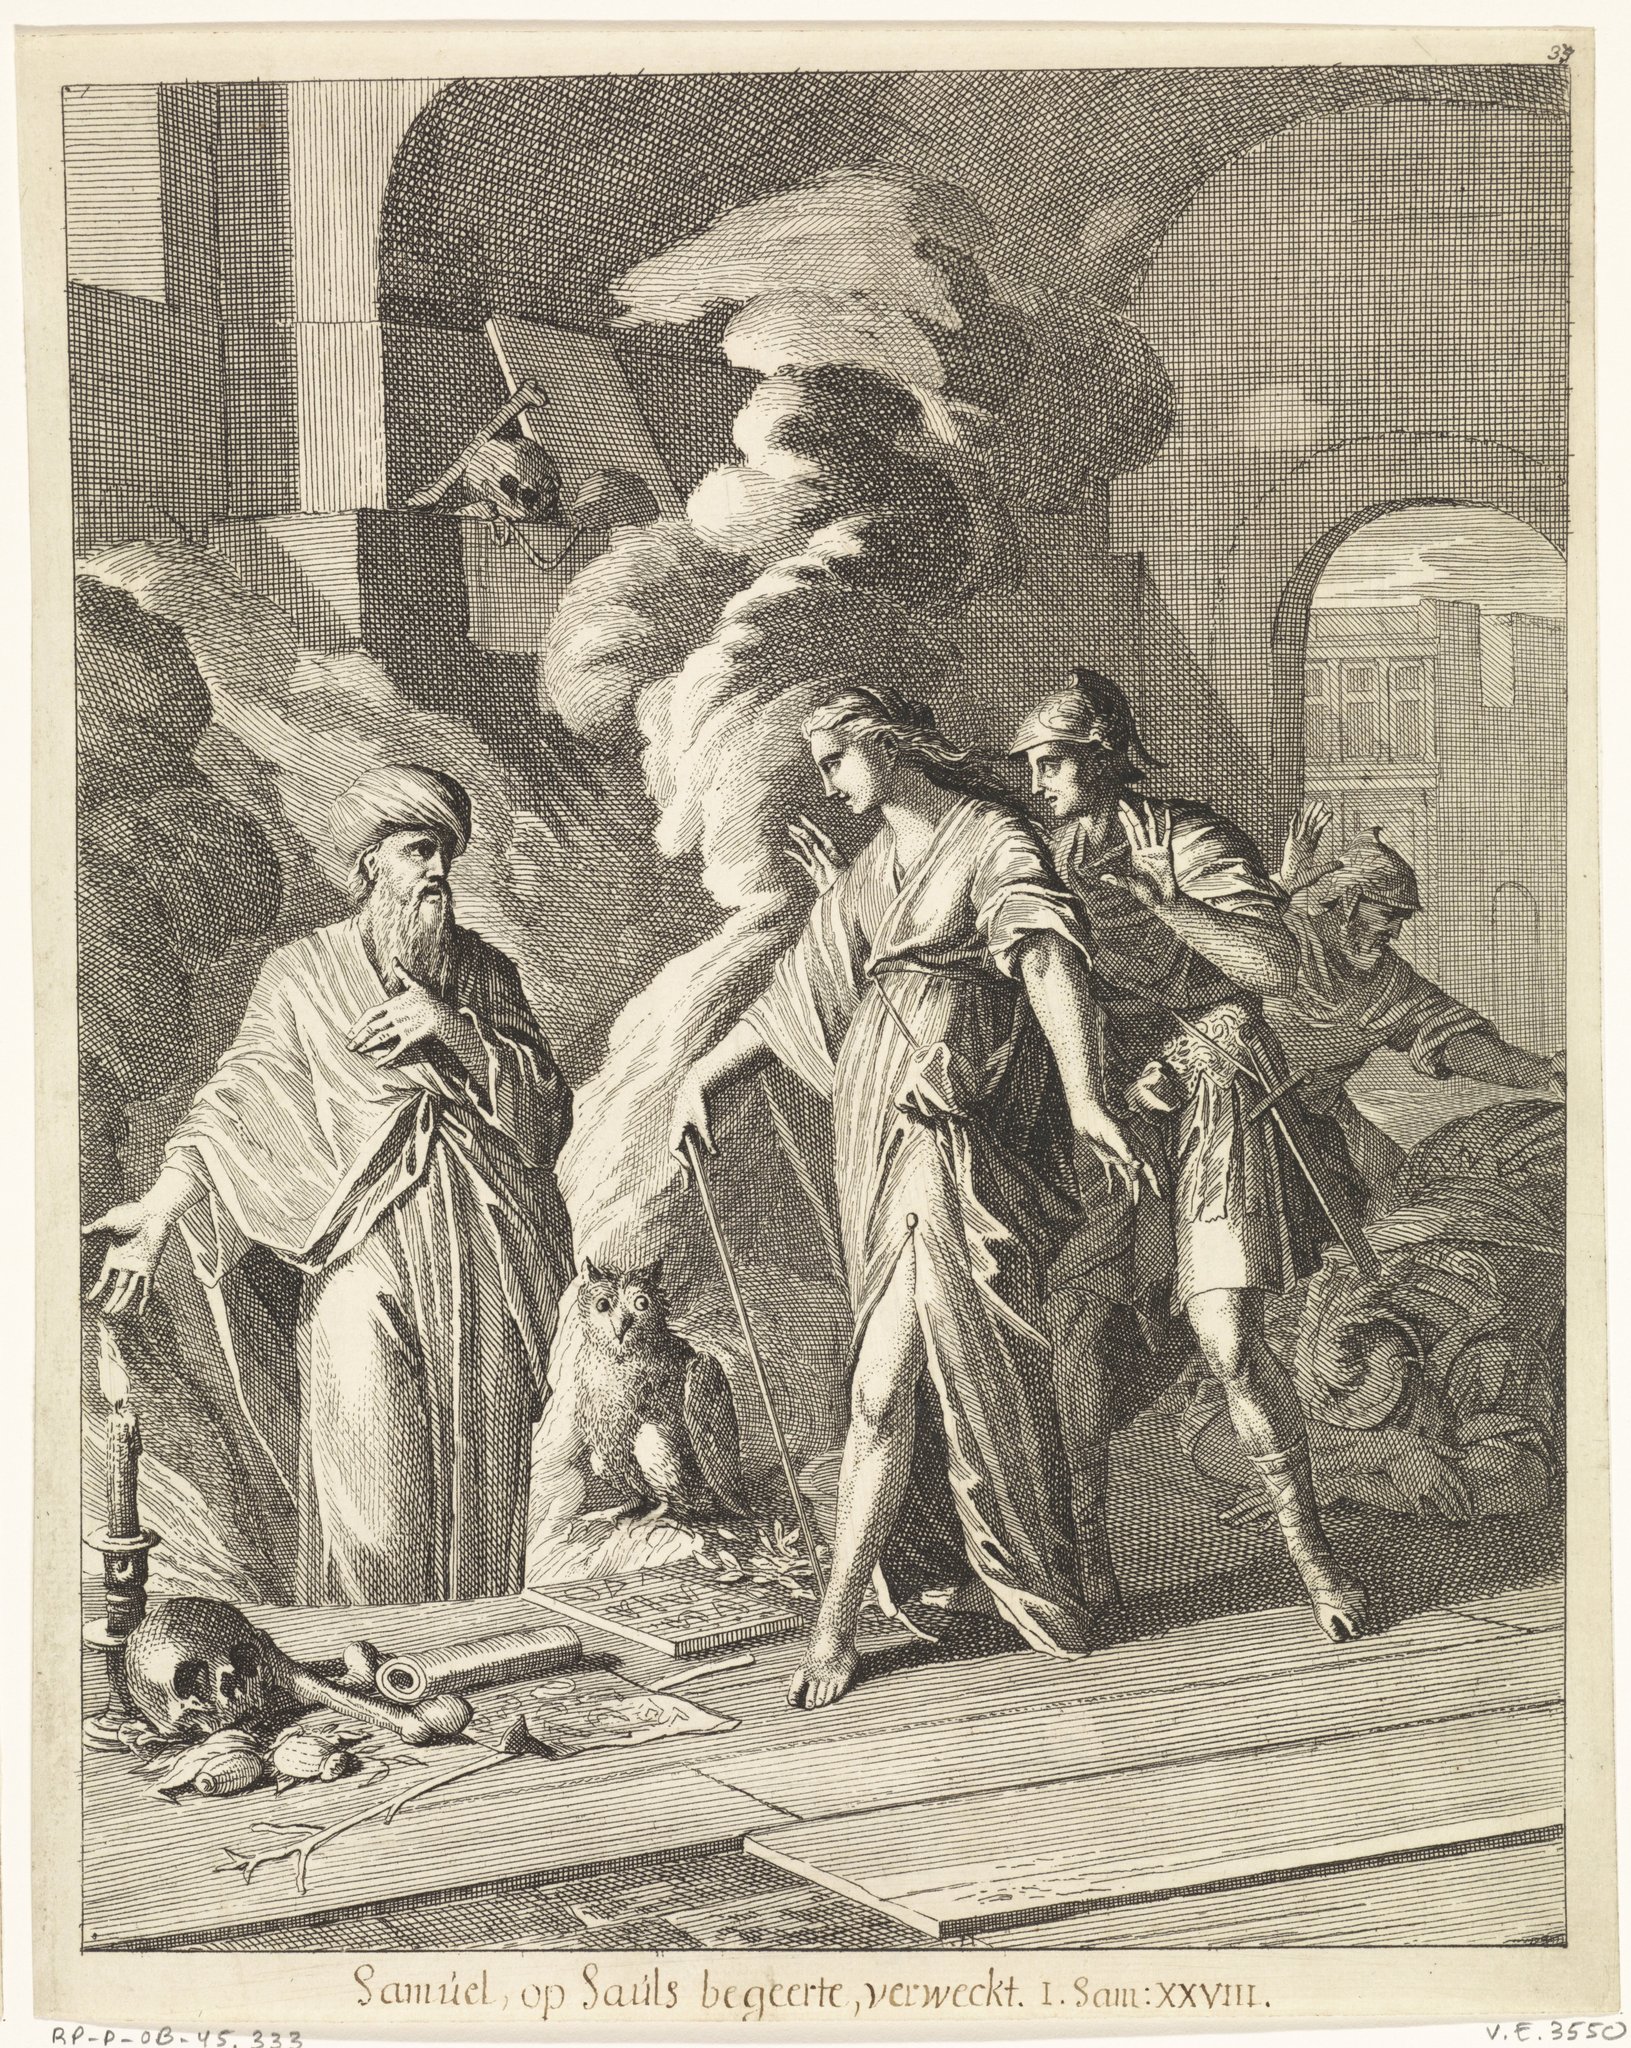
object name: print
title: Samuel verschijnt aan Saul bij de heks van Endor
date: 1708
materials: paper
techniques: etching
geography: nuremberg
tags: saul and the witch of endor (1 samuel 28:3-25)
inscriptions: collector's mark: Lugt 2228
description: Proefdruk van een prent welke is opgenomen als illustratie in: Historiae Celebriores Veteris Testamenti. Christoph Weigel, 1708.